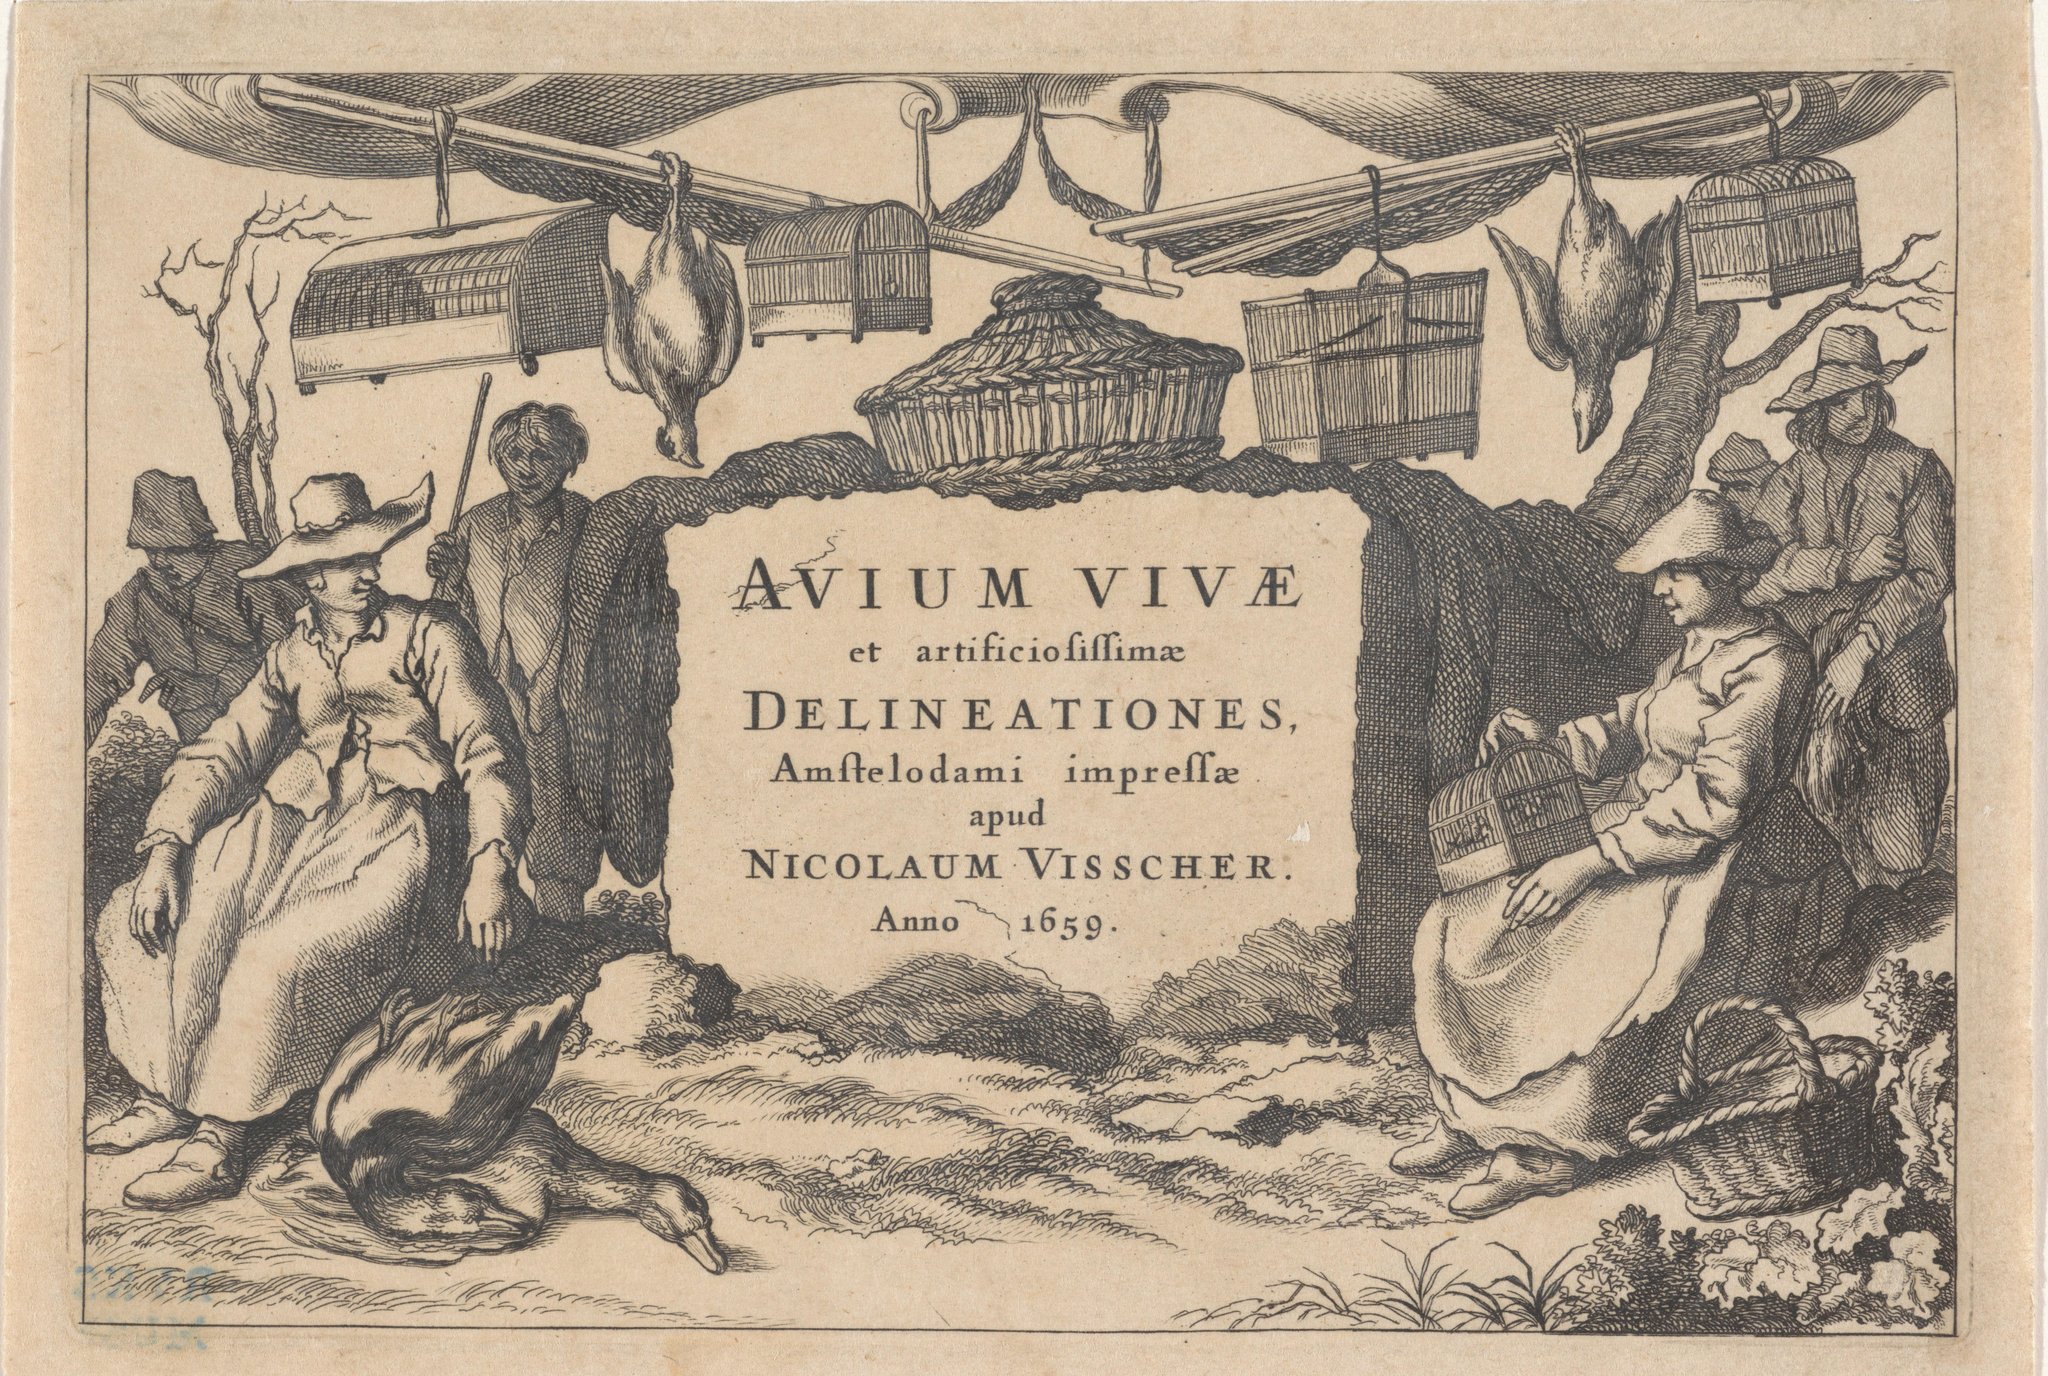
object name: titelprent, frontispice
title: Titelprent voor een reeks vogels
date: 1659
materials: paper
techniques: engraving, etching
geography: amsterdam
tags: empty bird cage, birds, bird in a cage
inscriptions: collector's mark: Lugt 2165, collector's mark: Lugt 240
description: Titelprent voor een reeks vogels met mensen bij gekooide en gevangen vogels en ganzen.